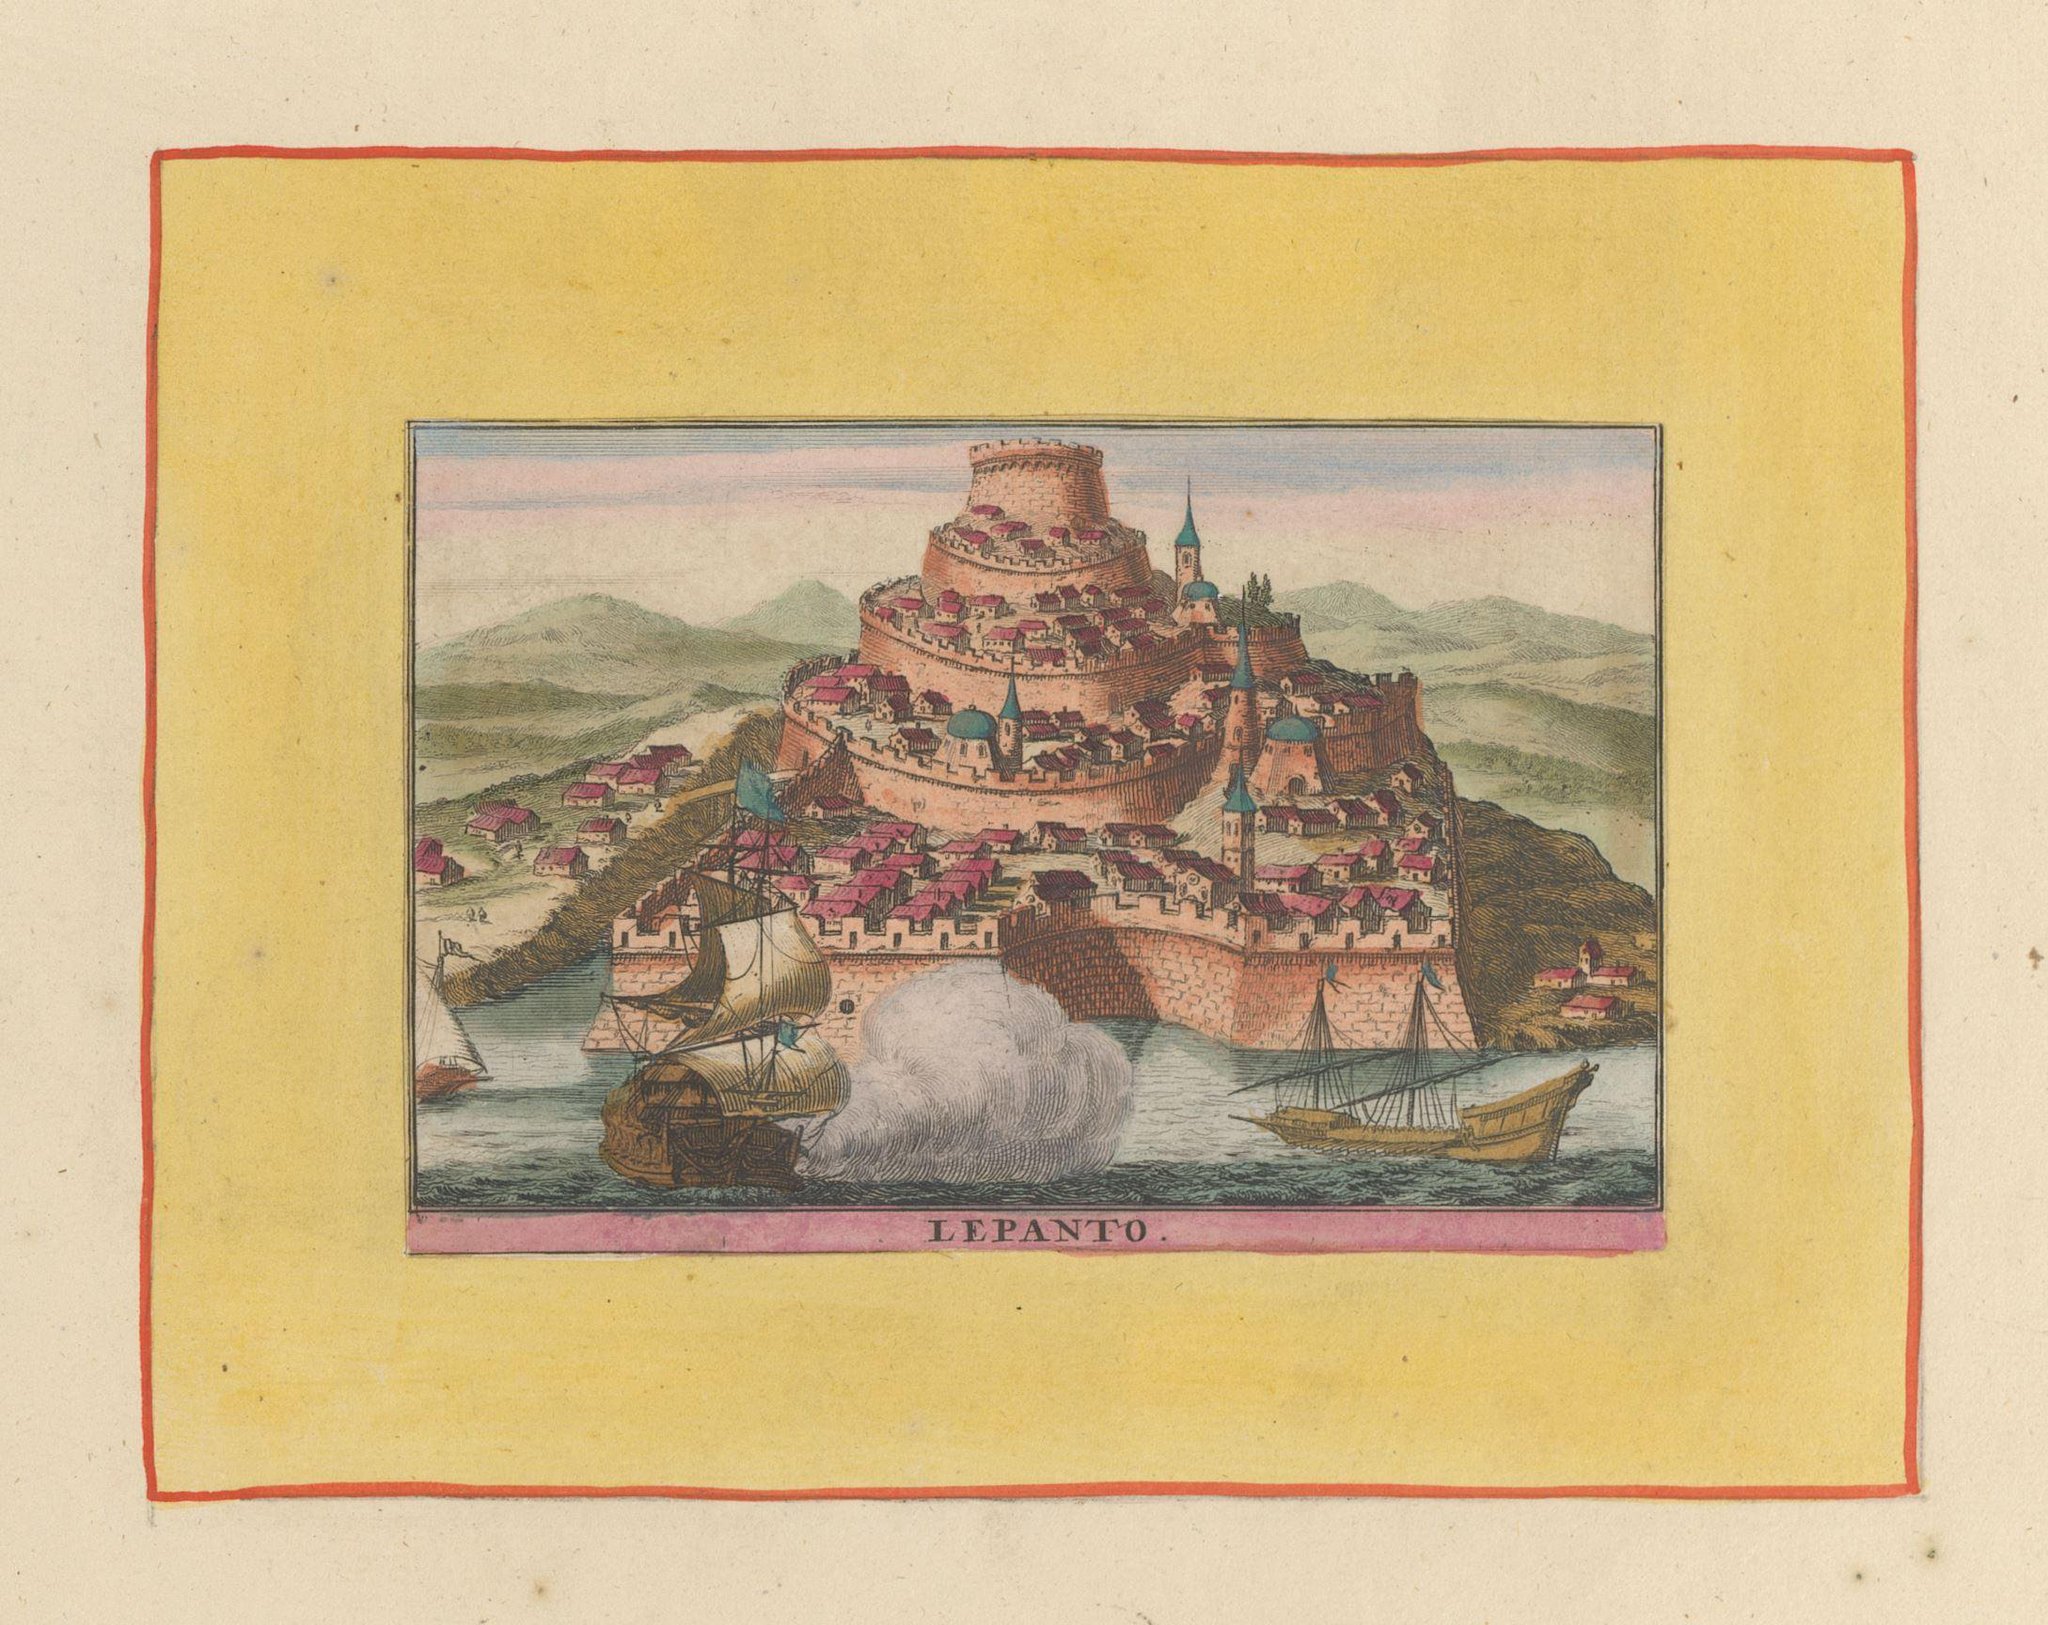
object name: print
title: Gezicht op Nafpaktos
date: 1679-1702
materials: paper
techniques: colour, etching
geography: amsterdam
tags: fortress, city-view, and landscape with man-made constructions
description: Prent maakt deel uit van een set van 16 prenten met voorstellingen van Griekse vestingsteden, oorspronkelijk gedrukt op één blad, die gebruikt konden worden als sieraad rond een kaart.